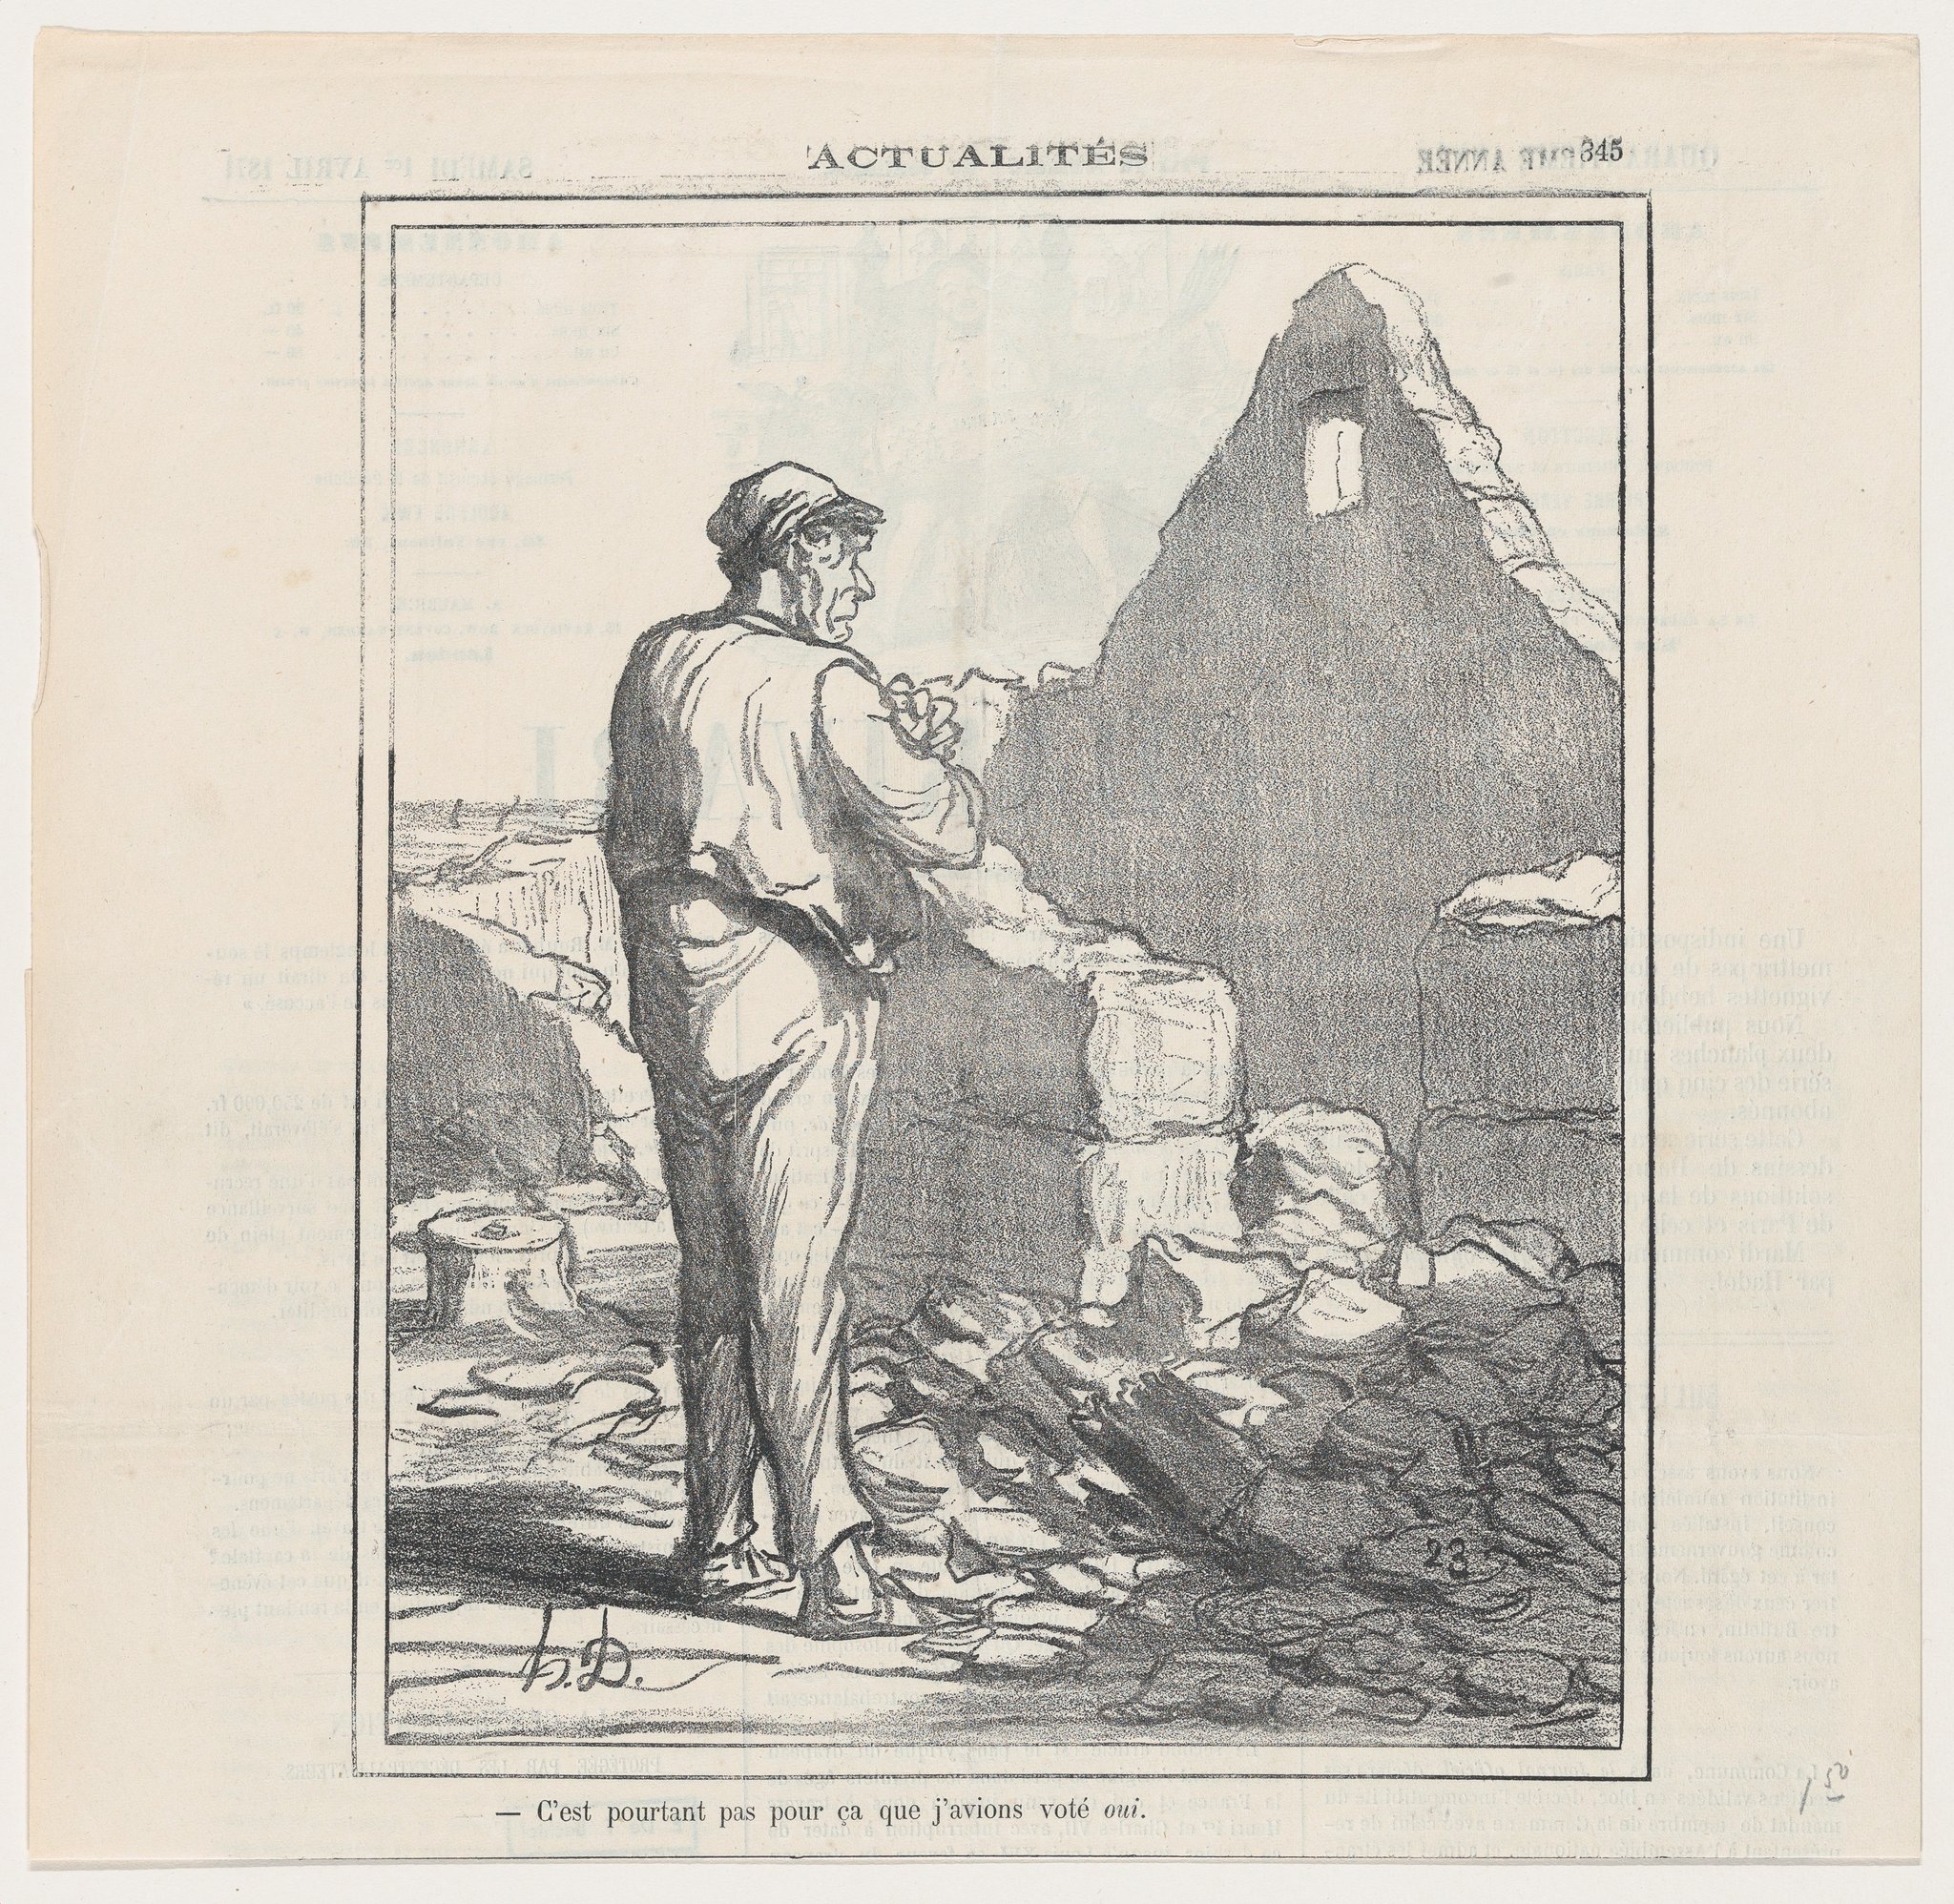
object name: print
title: I didn't vote yes for this!, from "News of the day"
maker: honoré daumier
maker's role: artist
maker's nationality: french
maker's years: 1808-1879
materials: paper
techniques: lithograph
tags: satire,men